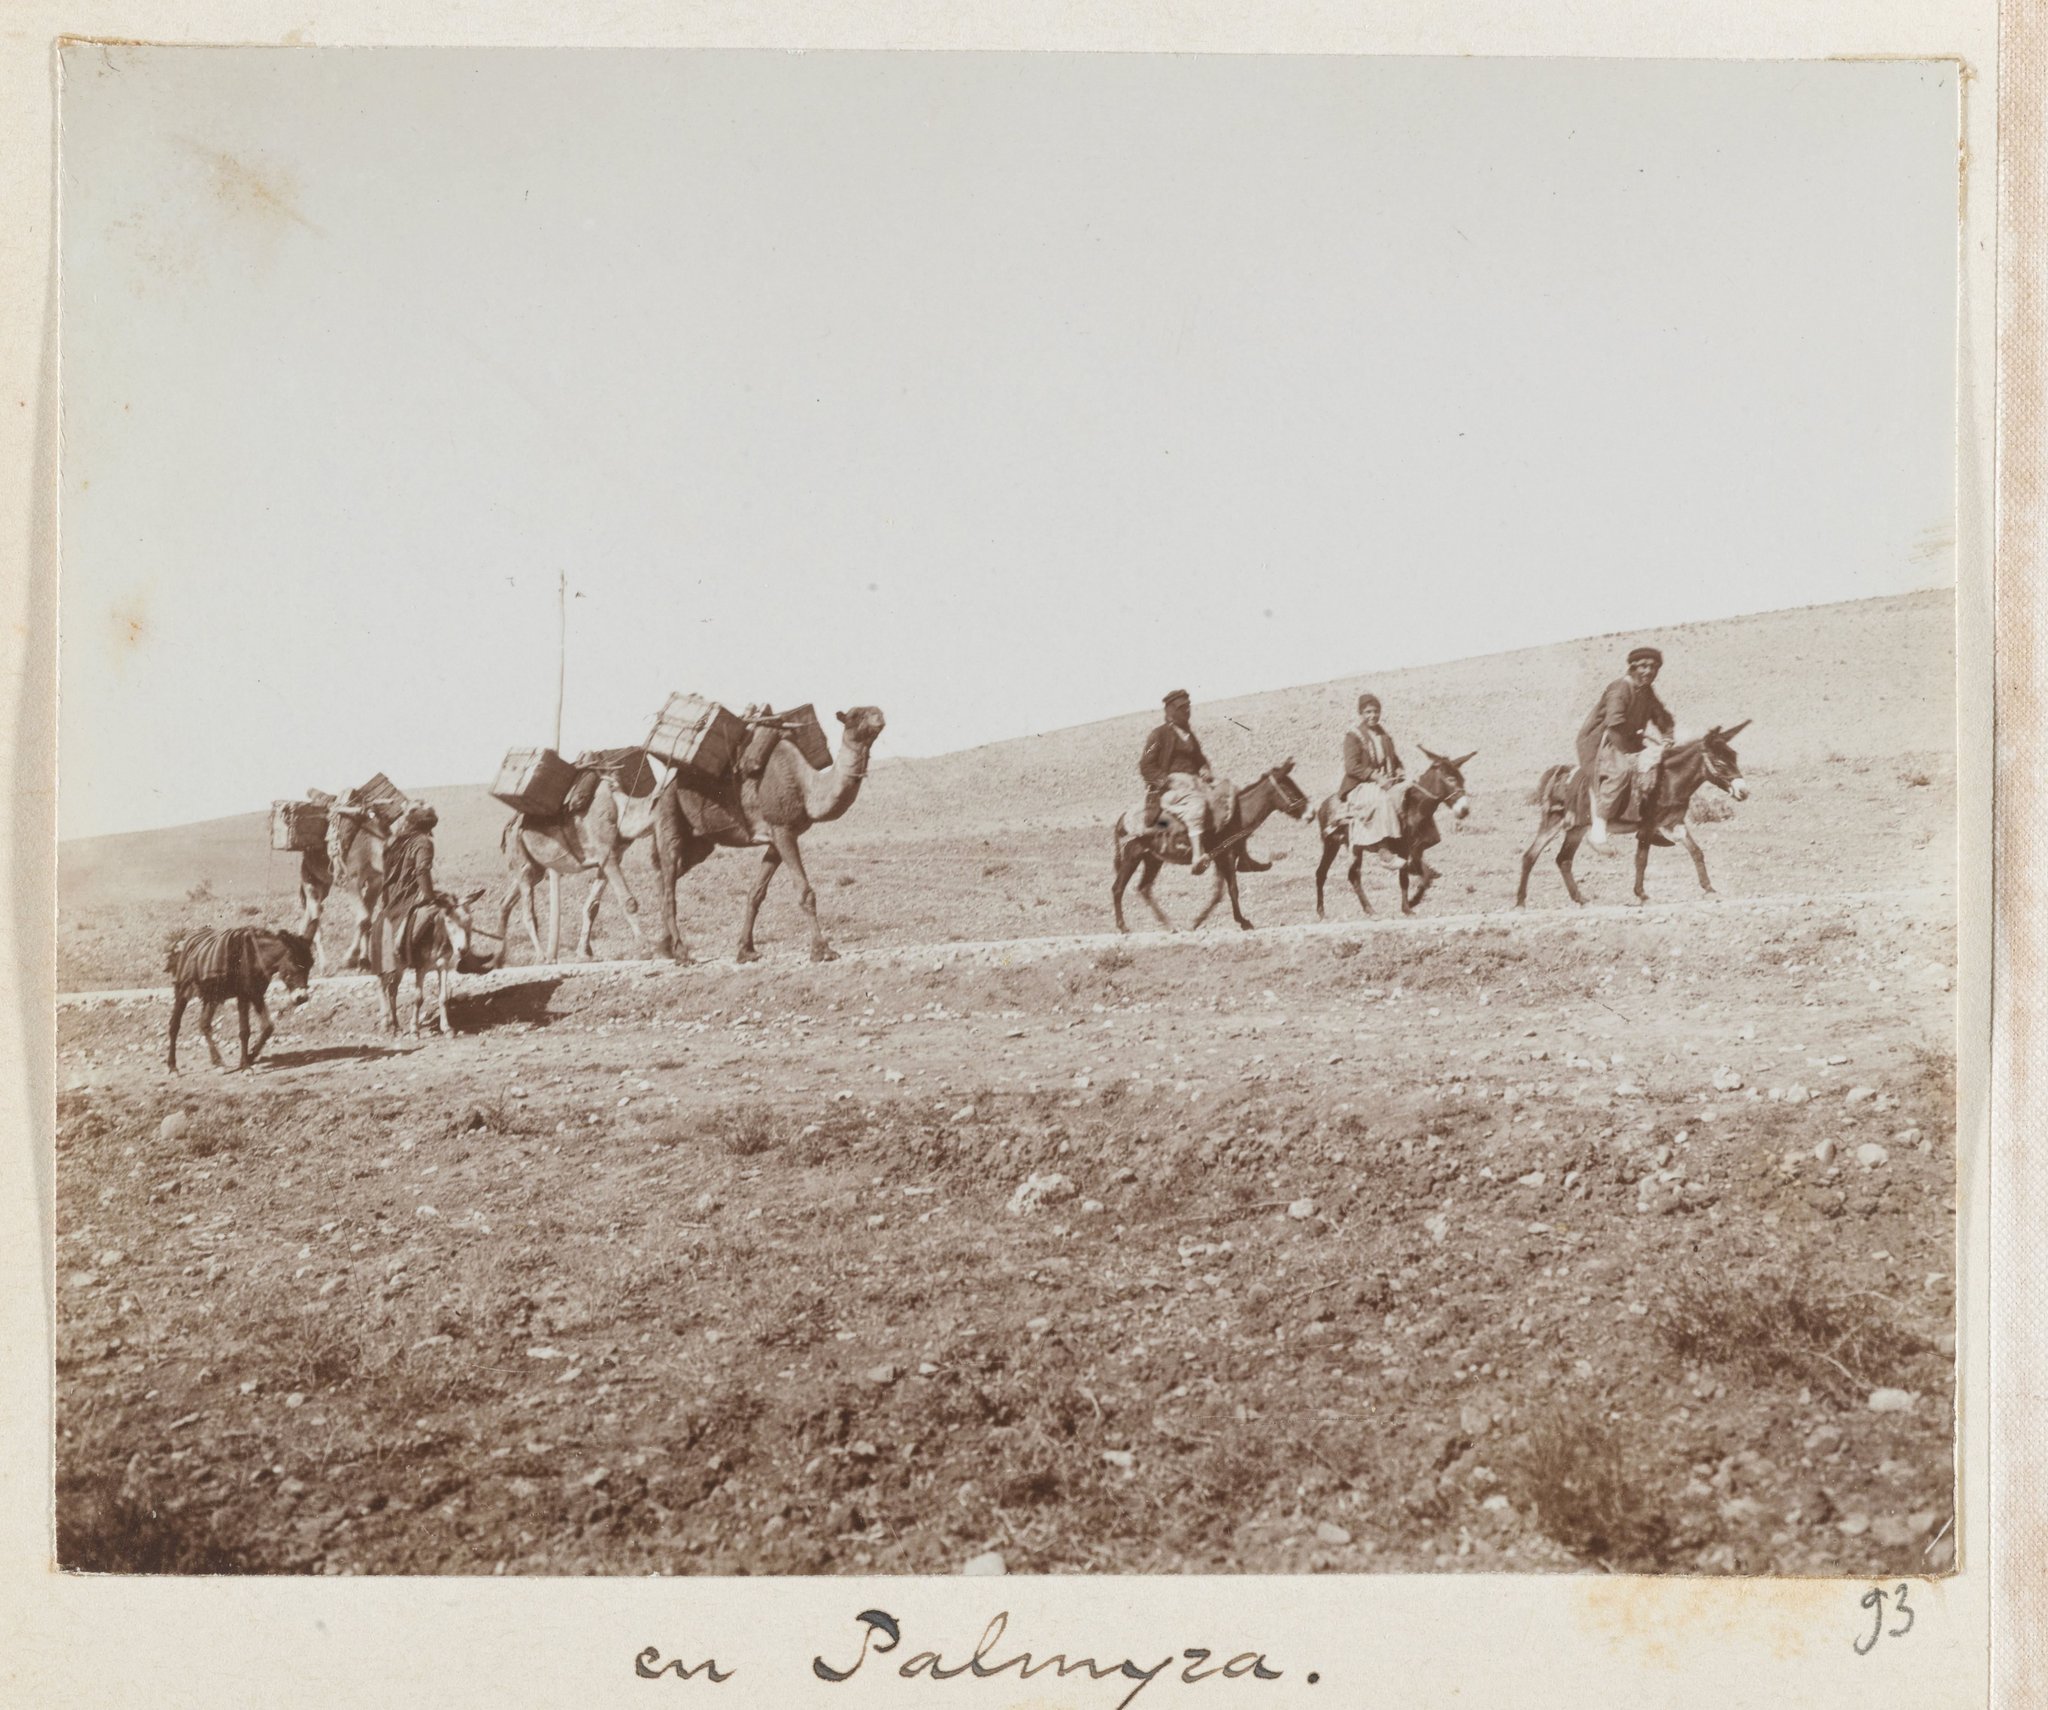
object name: photograph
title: Karavanen in de Bekavallei onderweg naar Baalbek, Libanon en Palmyra, Syrië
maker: johannes lodewijk heldring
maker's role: fotograaf, predikant, schrijver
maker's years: 1852-1923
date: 1898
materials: paper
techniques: collodion silver print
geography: bekavallei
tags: hoofed animals: dromedary